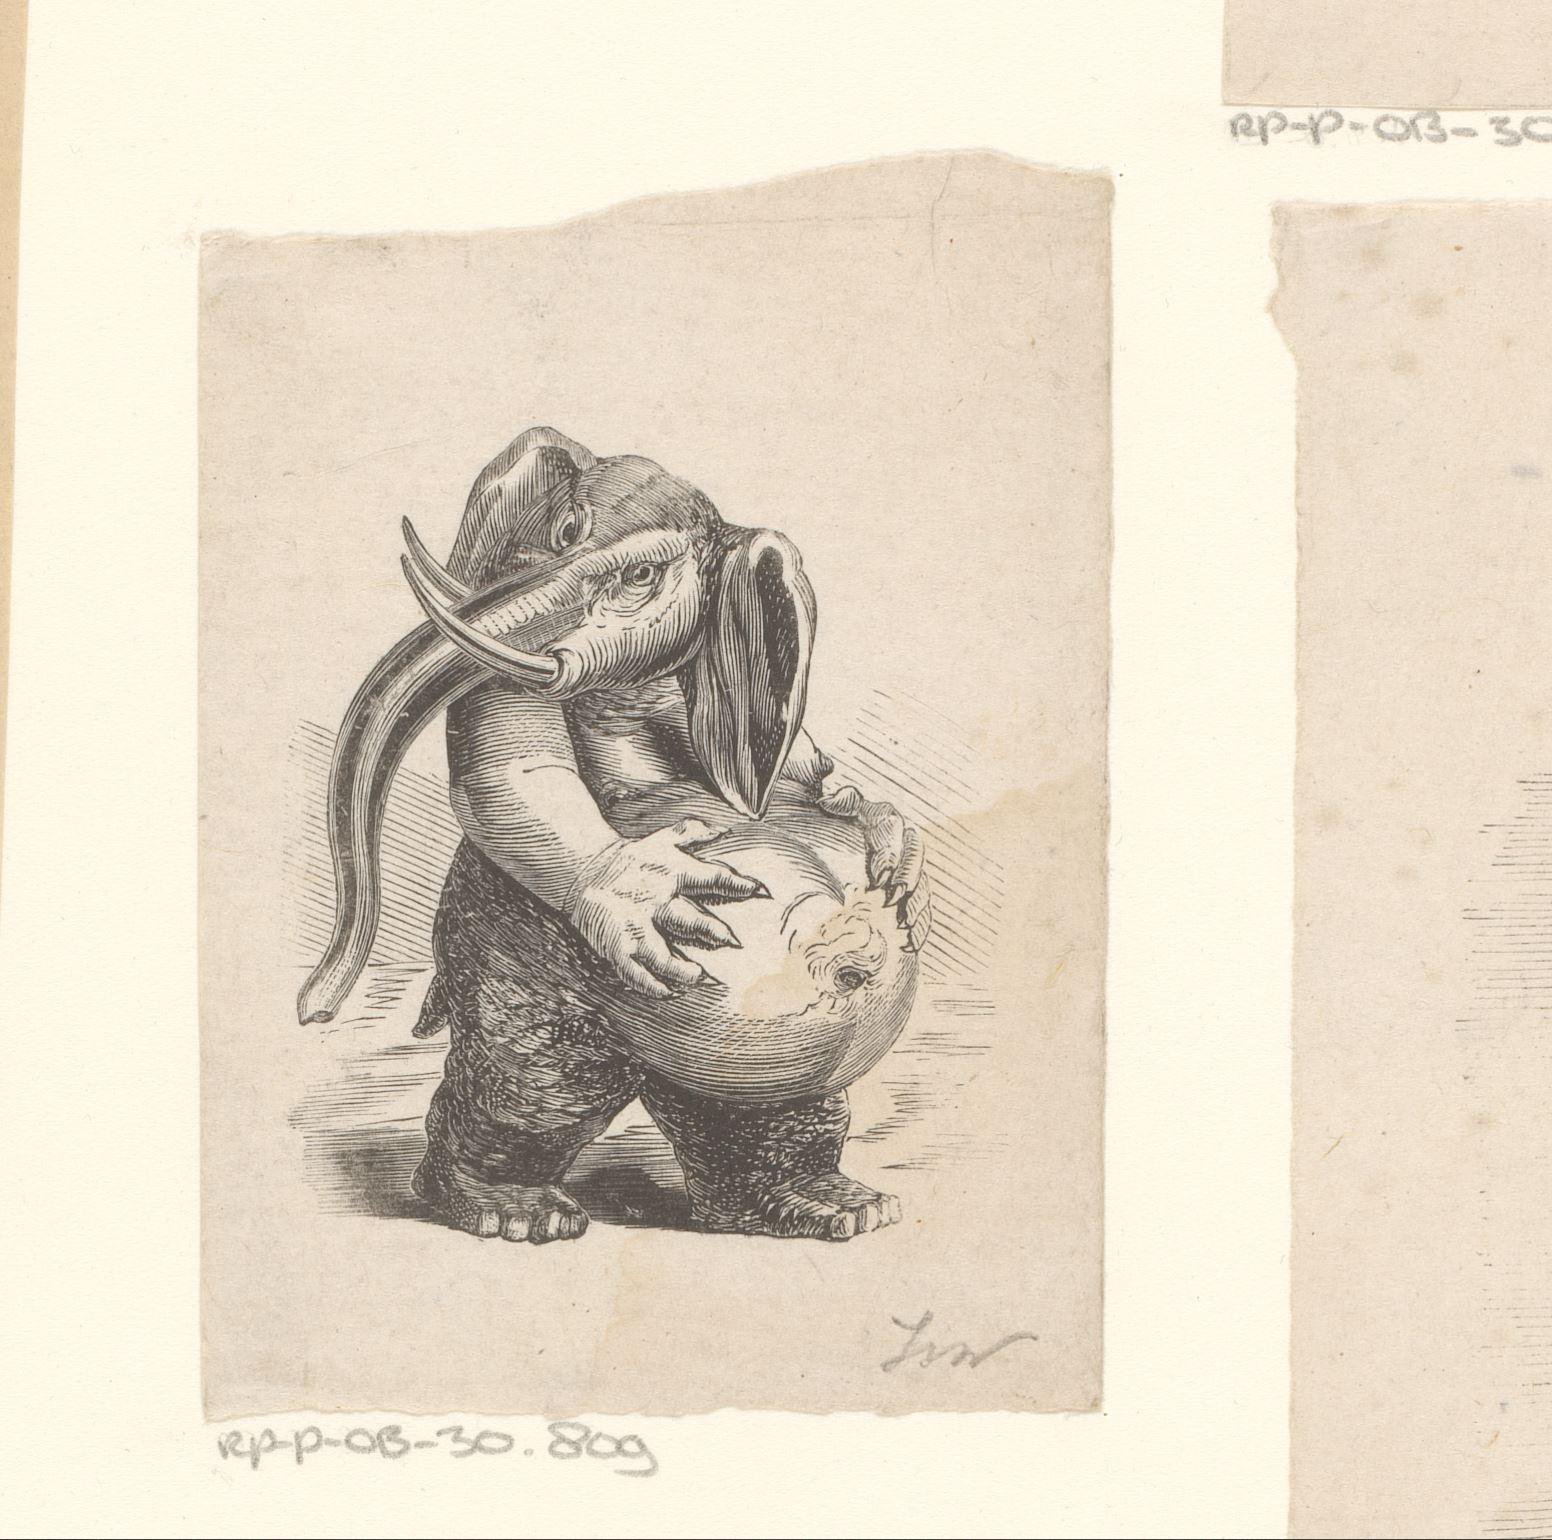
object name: print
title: Staande olifant met twee klauwen en een ronde buik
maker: isaac weissenbruch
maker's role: print maker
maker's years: 1826-1912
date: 1836-1912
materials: paper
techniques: engraving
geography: netherlands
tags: trunked animals: elephant